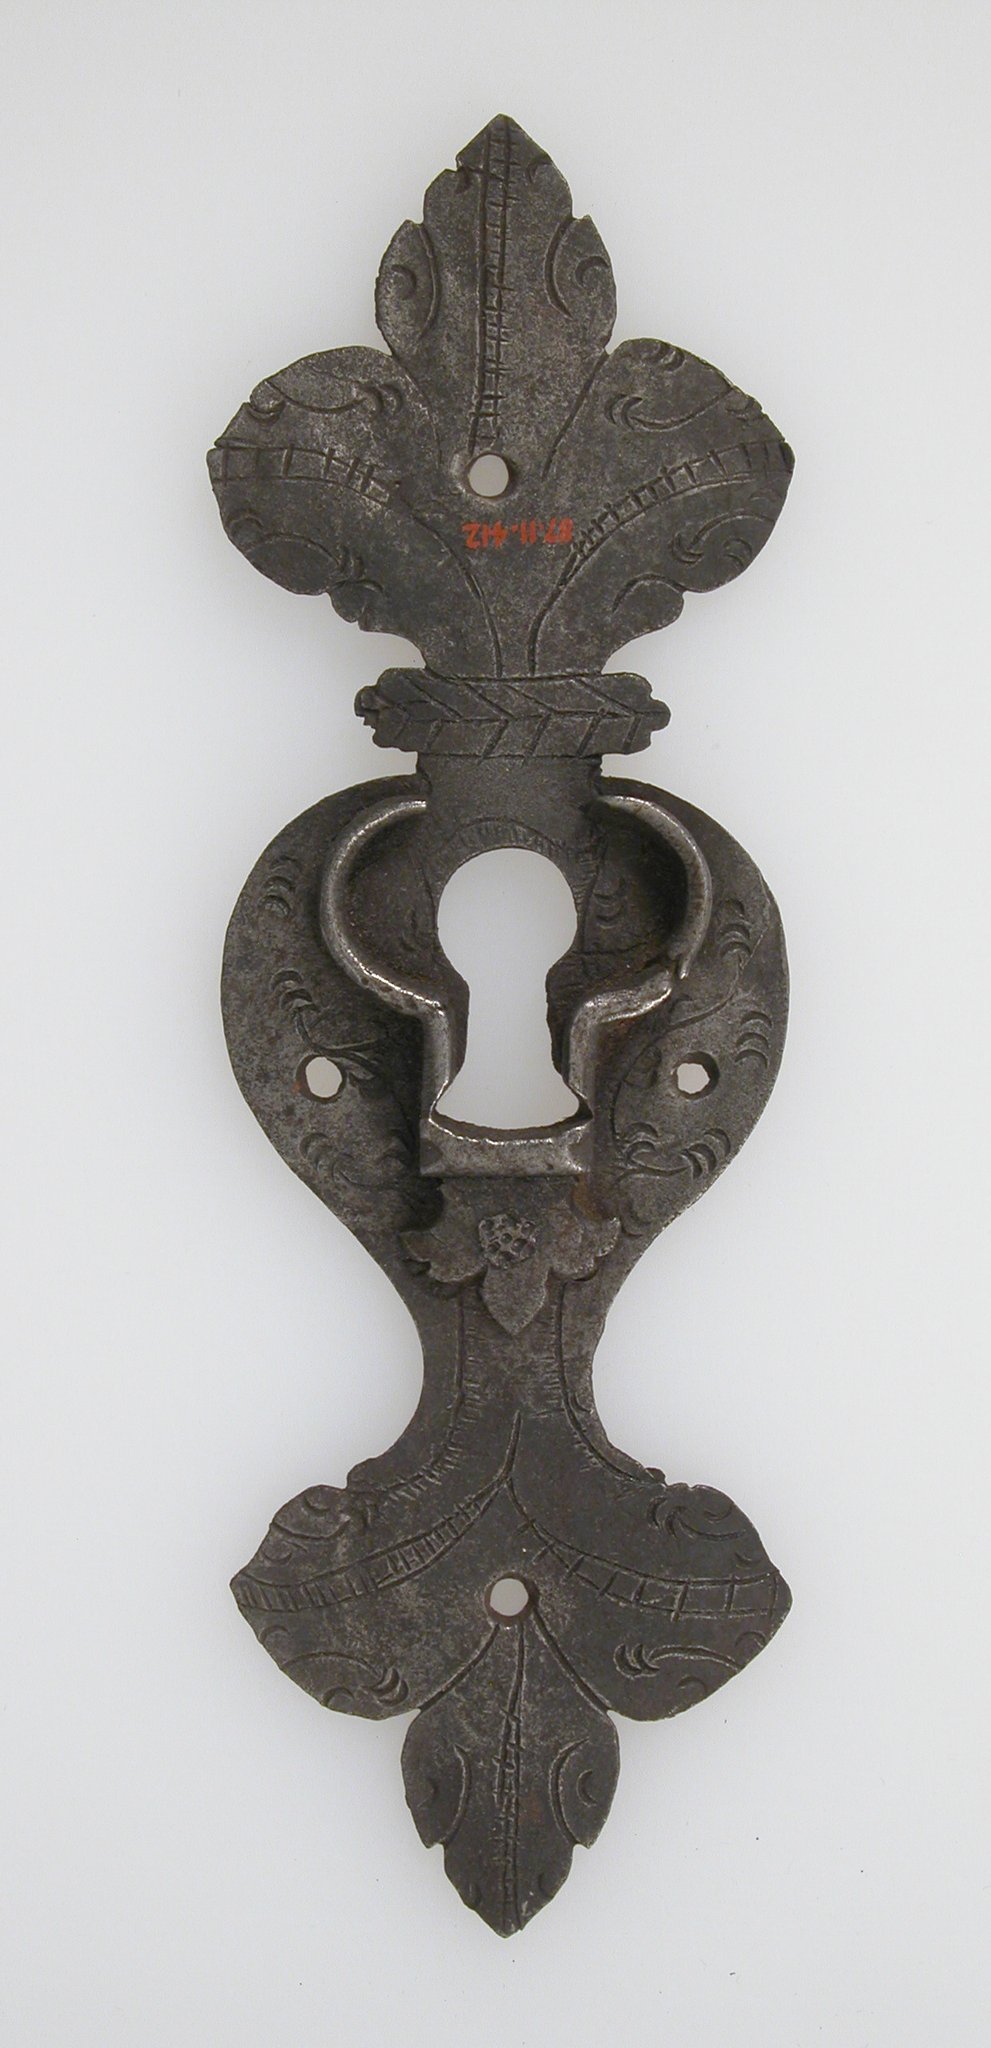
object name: escutcheon plate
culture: german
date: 1501-1600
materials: iron